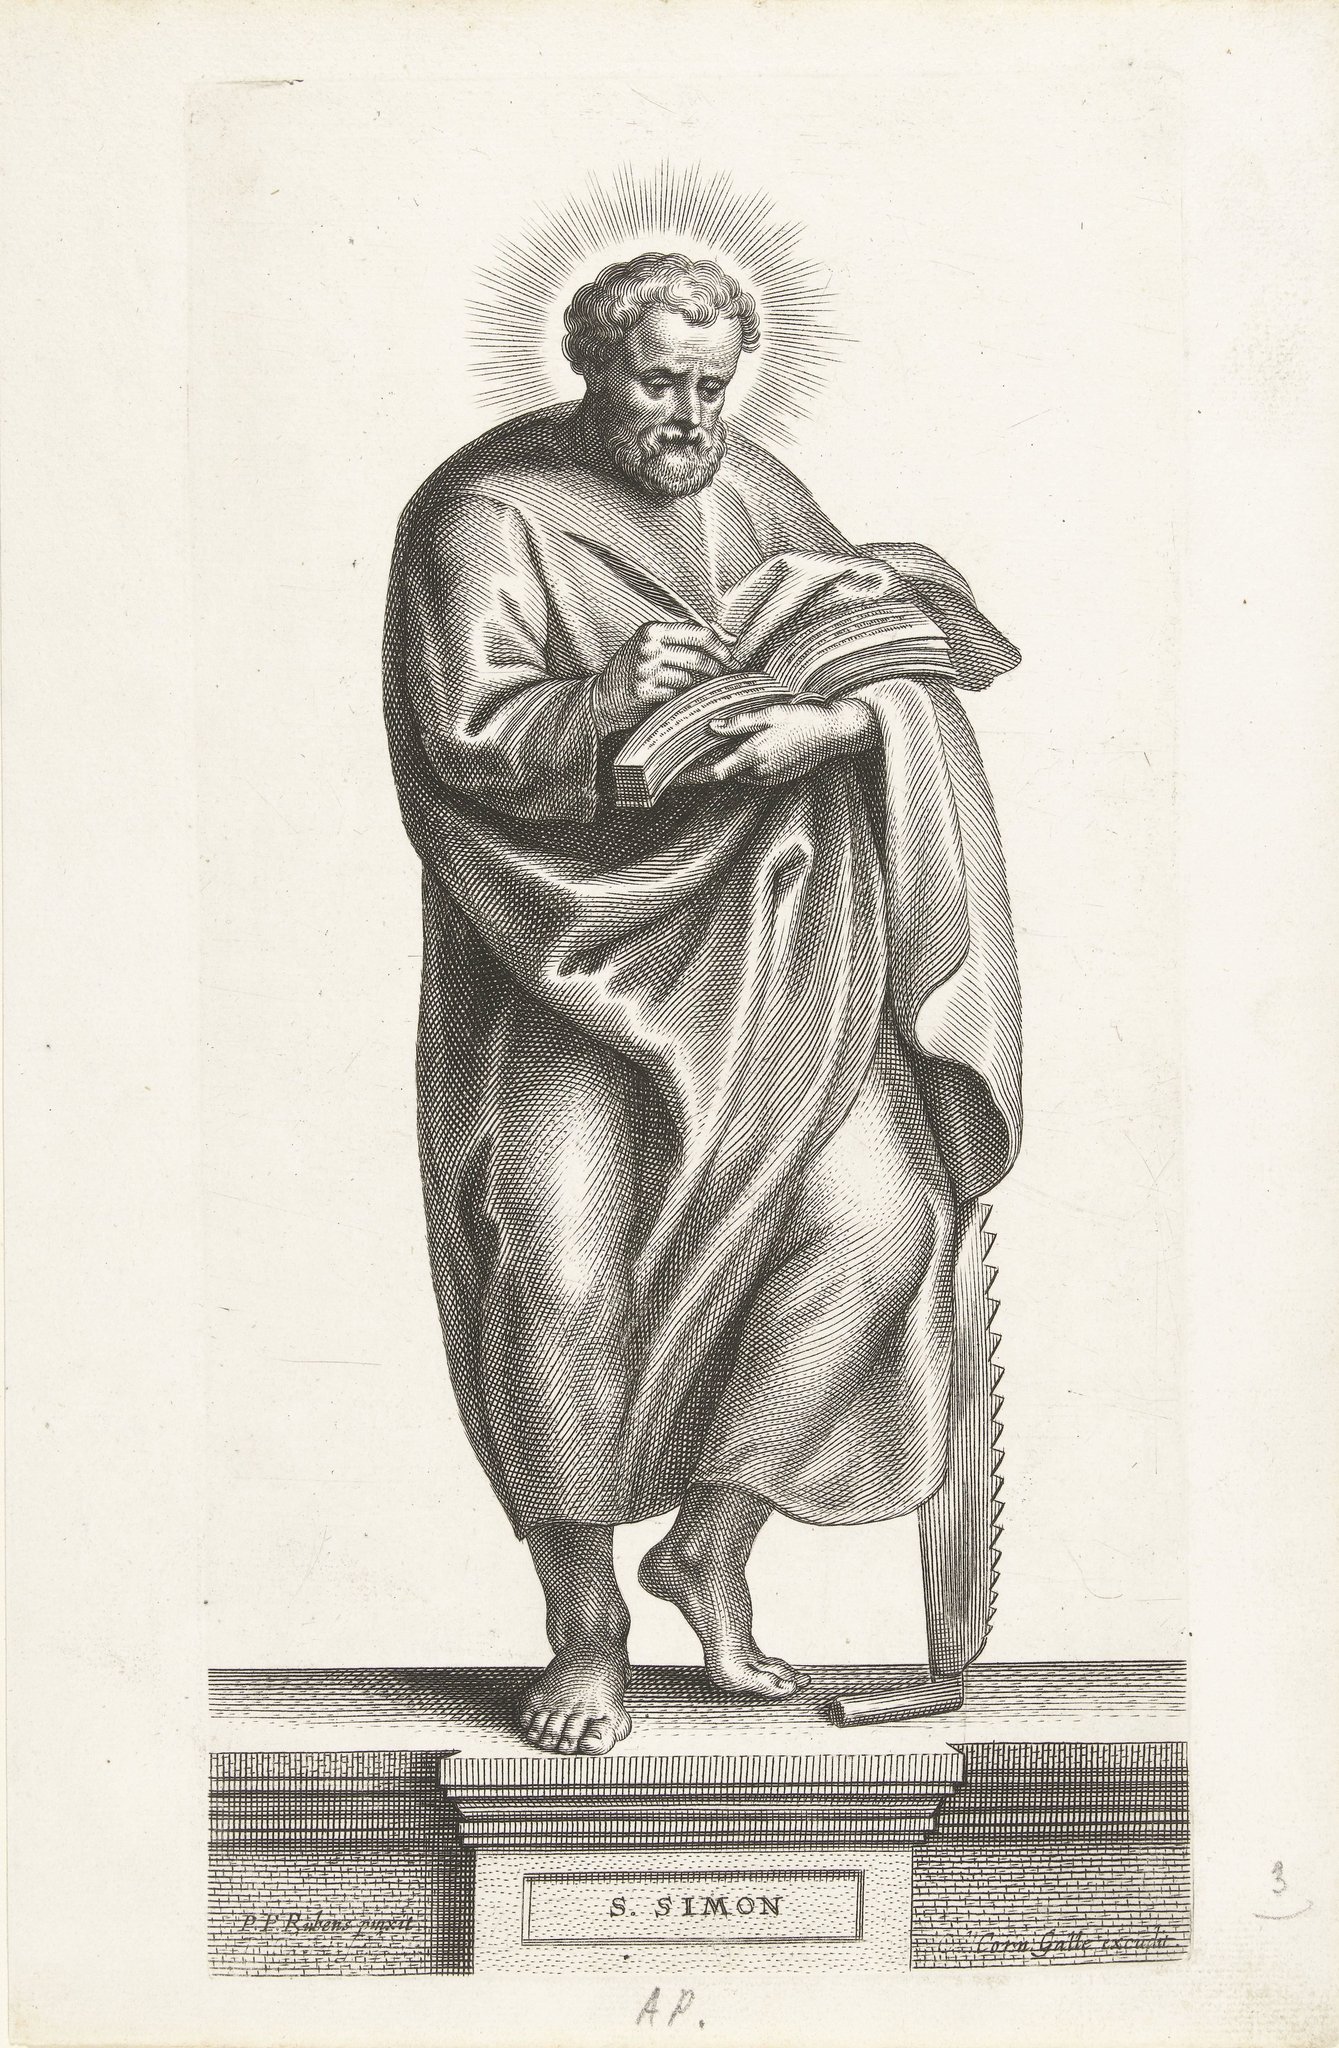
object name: print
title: Heilige Simon de Zeloot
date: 1639-1670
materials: paper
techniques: engraving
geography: antwerp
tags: the apostle simon zelotes (or simon the canaanite); possible attributes: book, saw, scroll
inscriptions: collector's mark: Lugt 2228, collector's mark: Lugt 2760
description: De prent toont de Heilige Simon de Zeloot. In zijn linkerhand zijn martelwerktuig, de zaag. De serie bestaat uit prenten gebaseerd op schilderijen van Peter Paul Rubens.